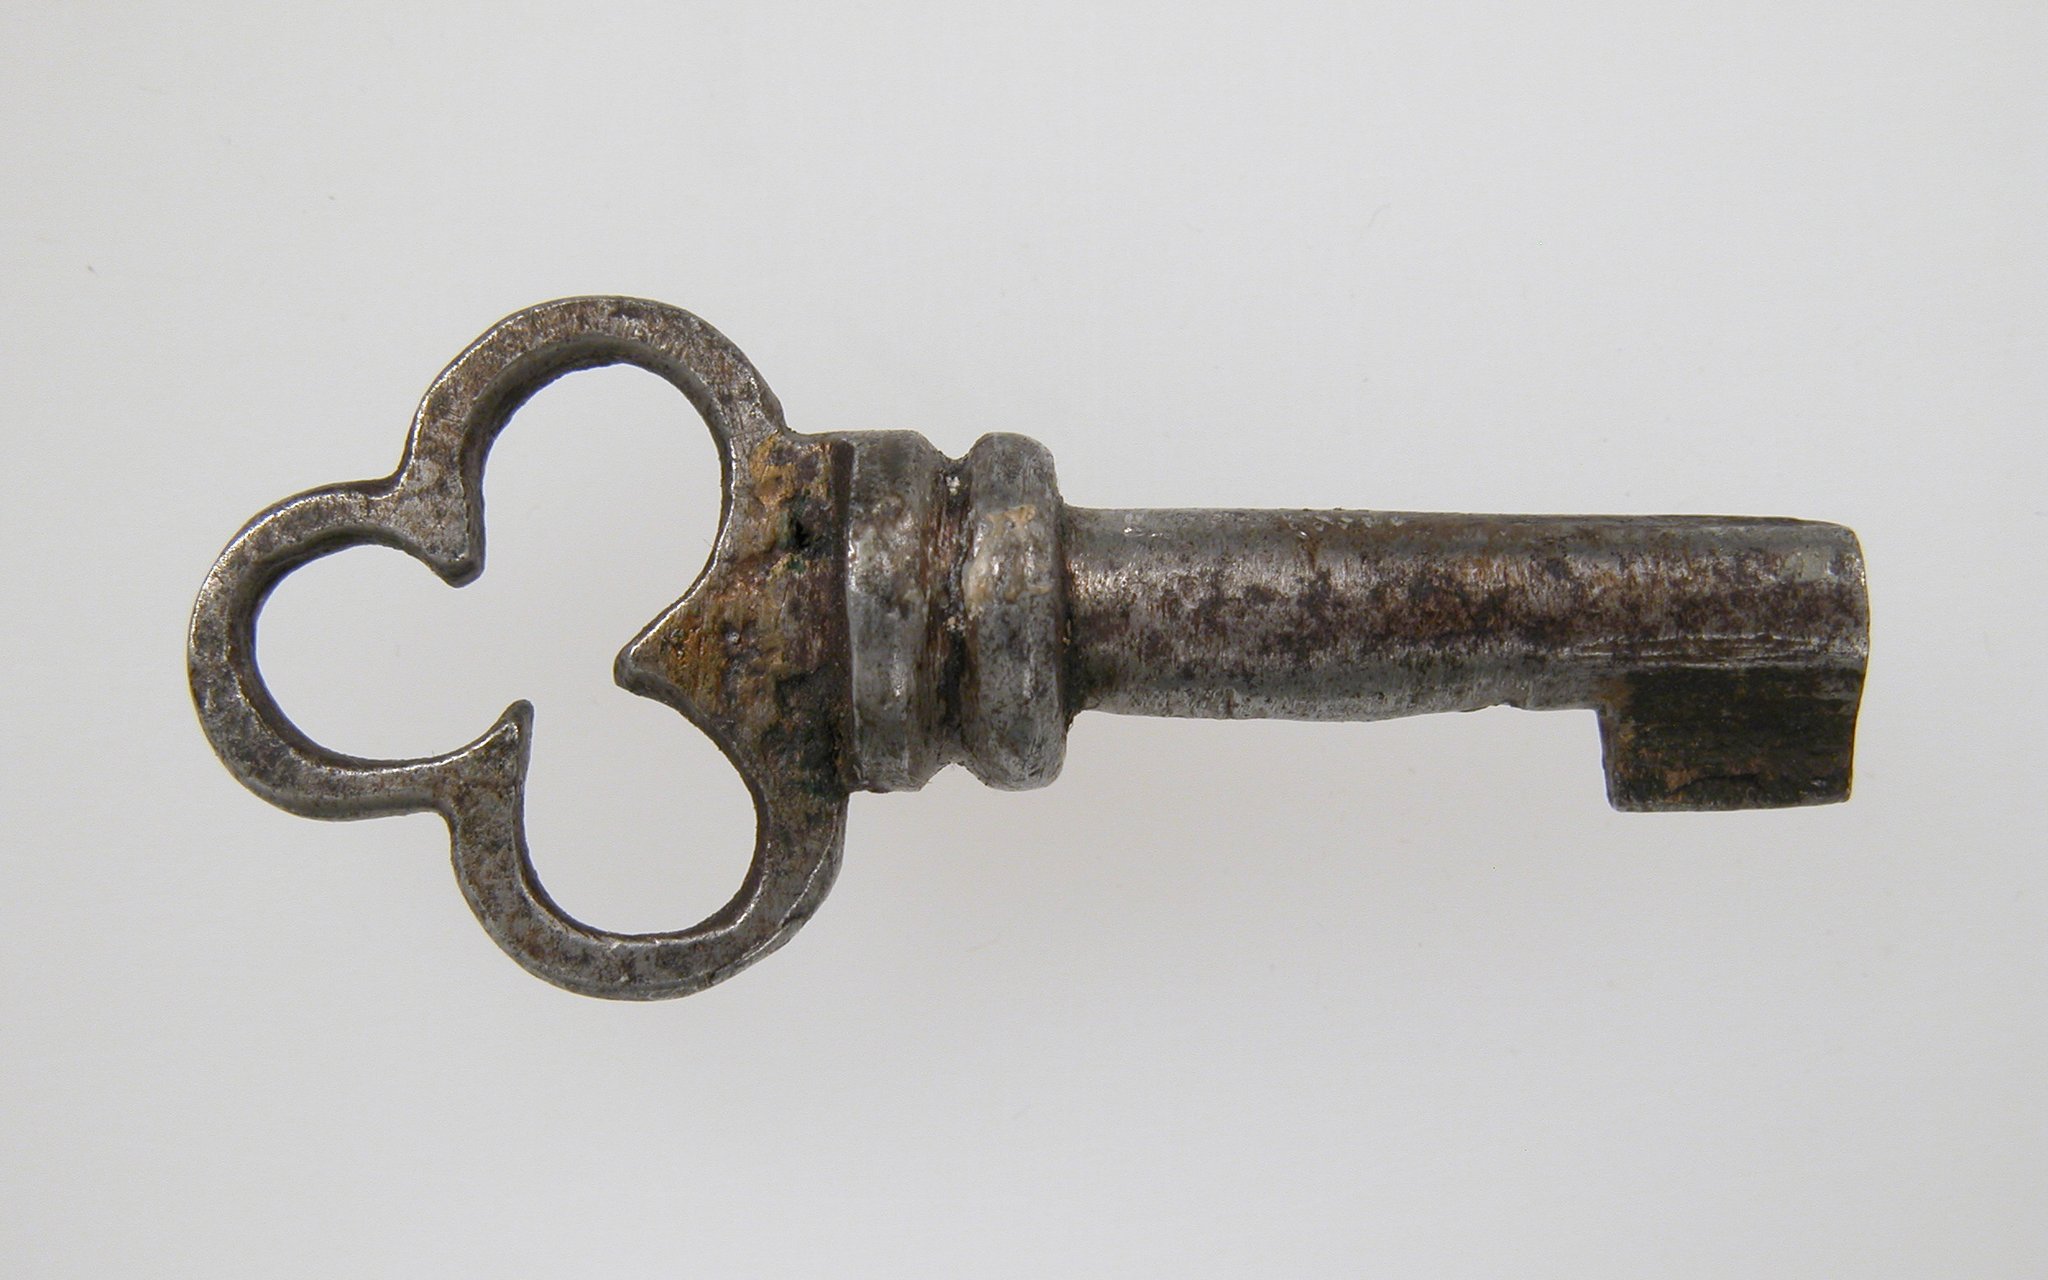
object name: key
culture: german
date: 1401-1500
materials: iron